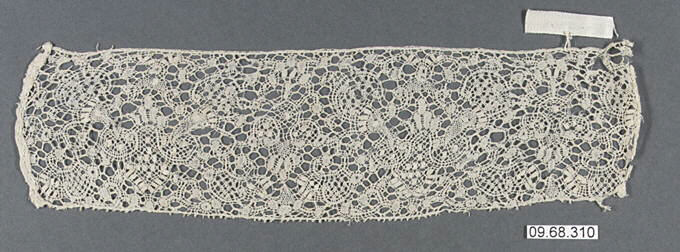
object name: strip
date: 1700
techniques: lace